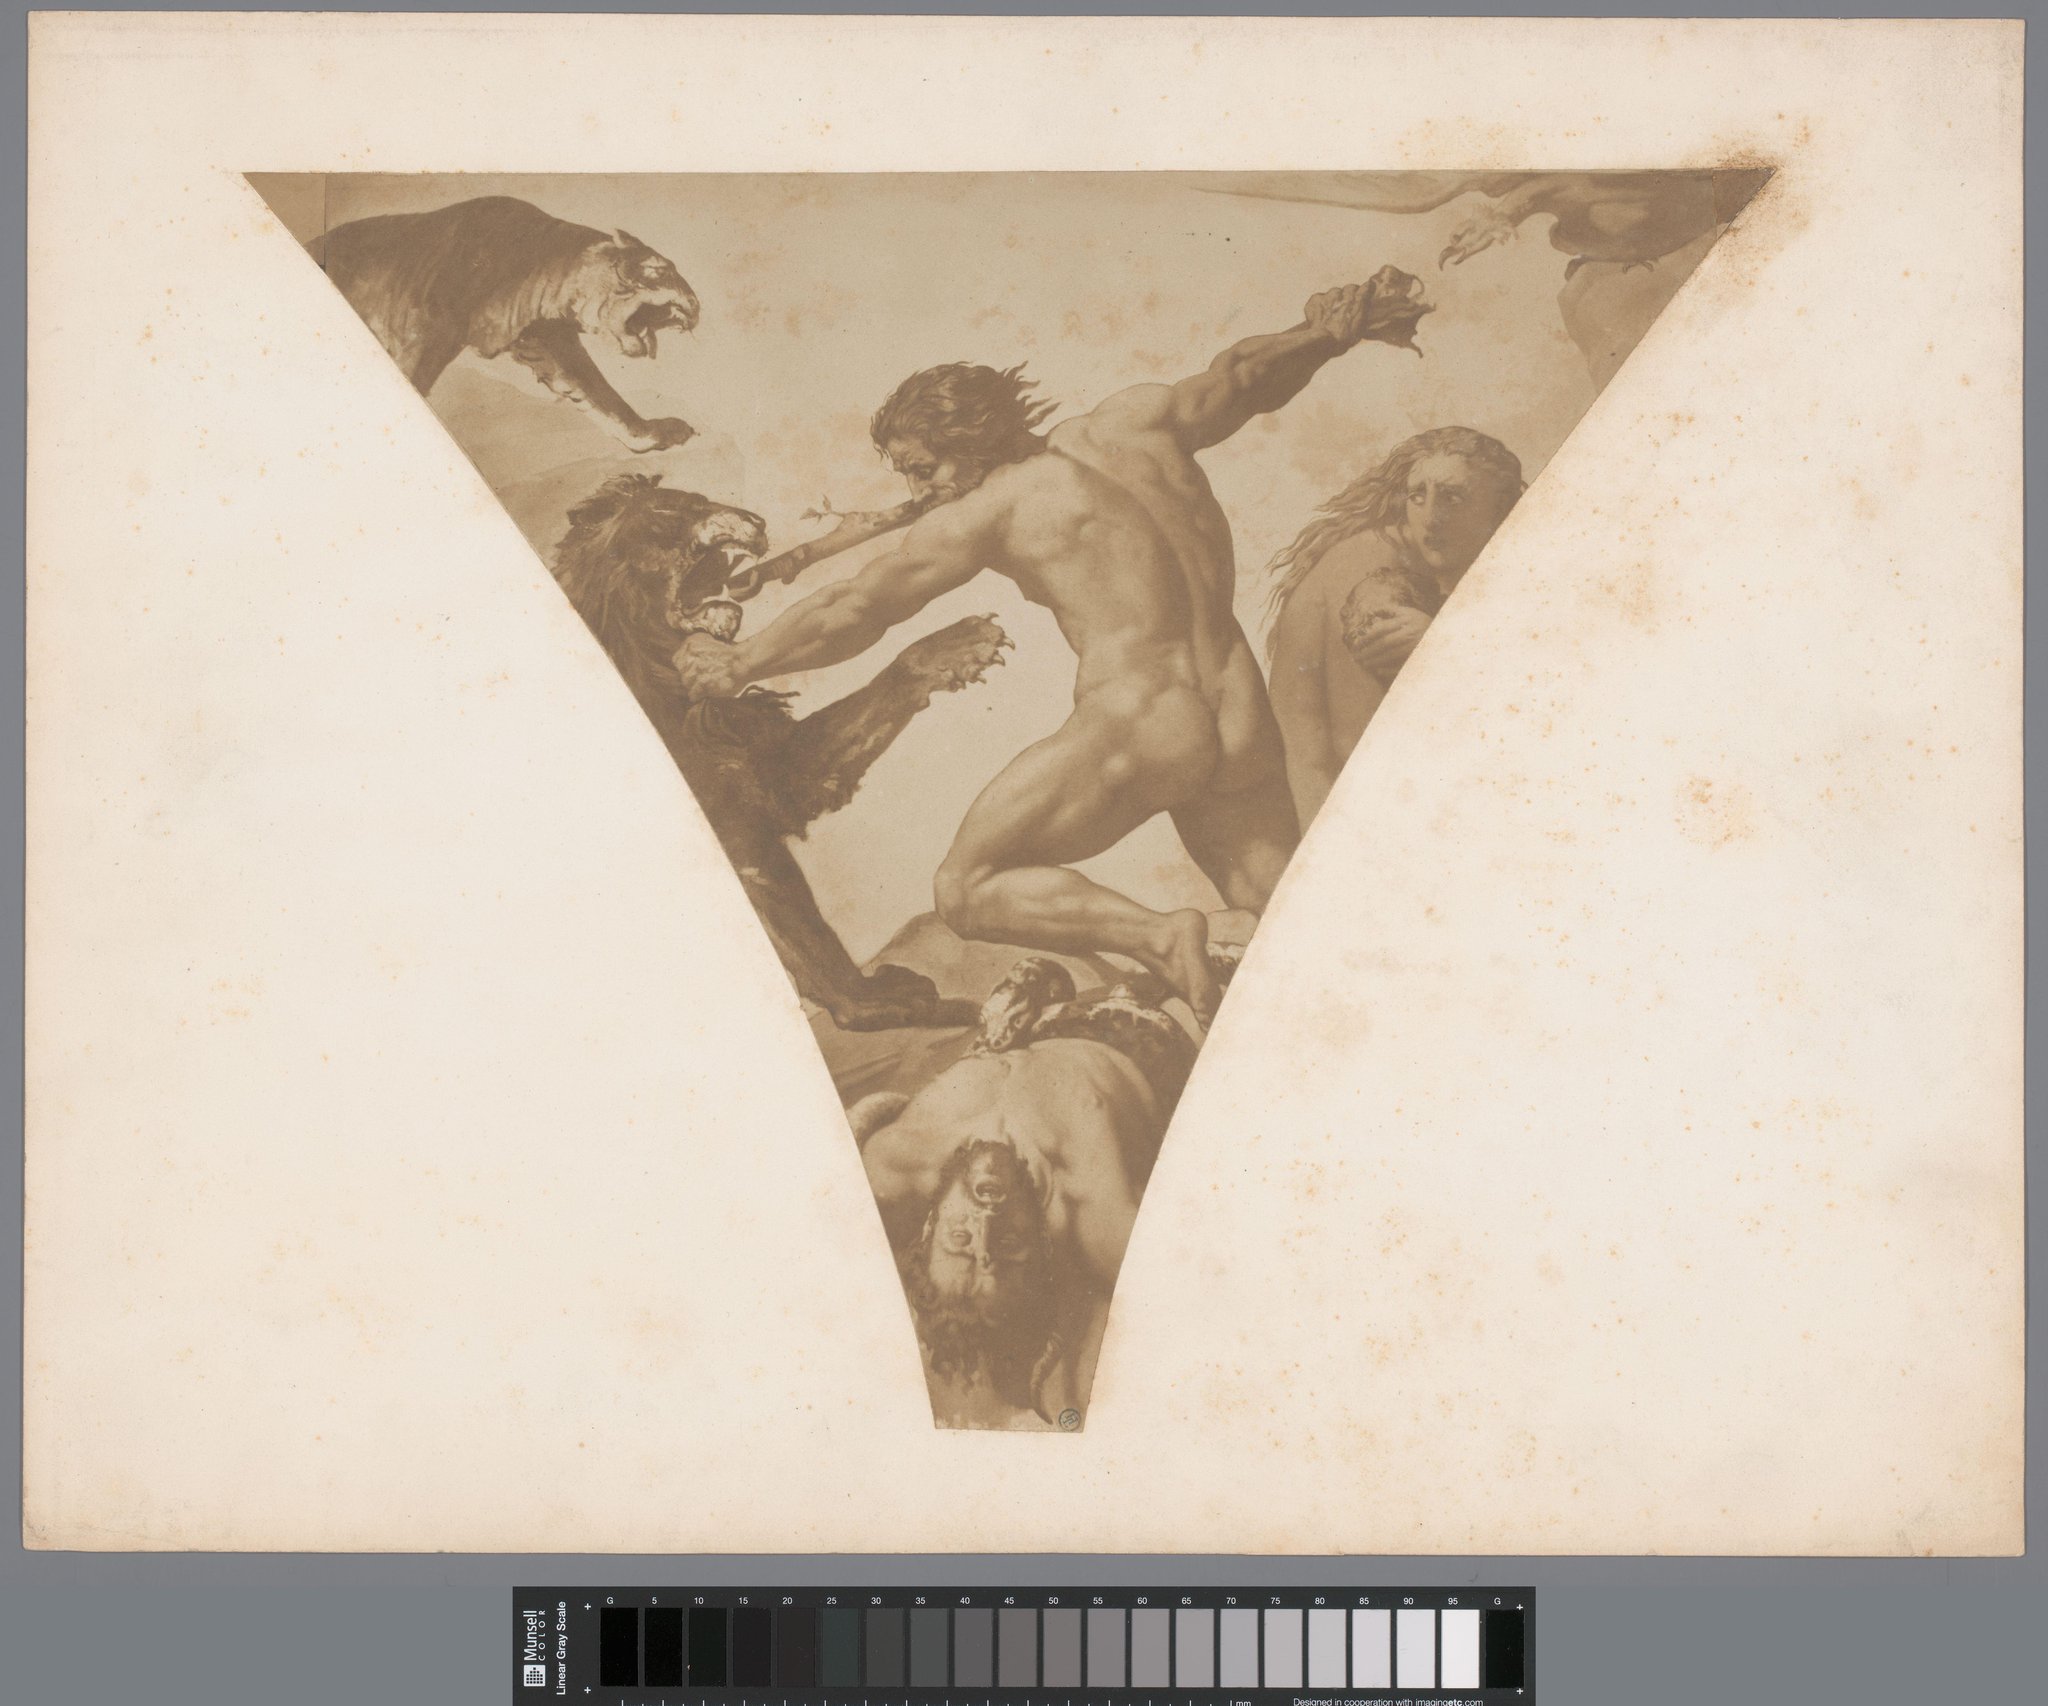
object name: photograph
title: Fotografische reproductie van decoratie aan plafond, Hotel de Ville, Parijs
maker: gustave le gray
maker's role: fotograaf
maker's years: 1820-1884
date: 1852-1853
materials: cardboard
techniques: salted paper print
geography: paris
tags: paris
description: Maakt onderdeel uit van een serie van 18 bladen met foto's van de cartons voor de plafondschilderingen door Henri Lehmann voor de Galerie des Fêtes in het Hotel de Ville, Parijs.